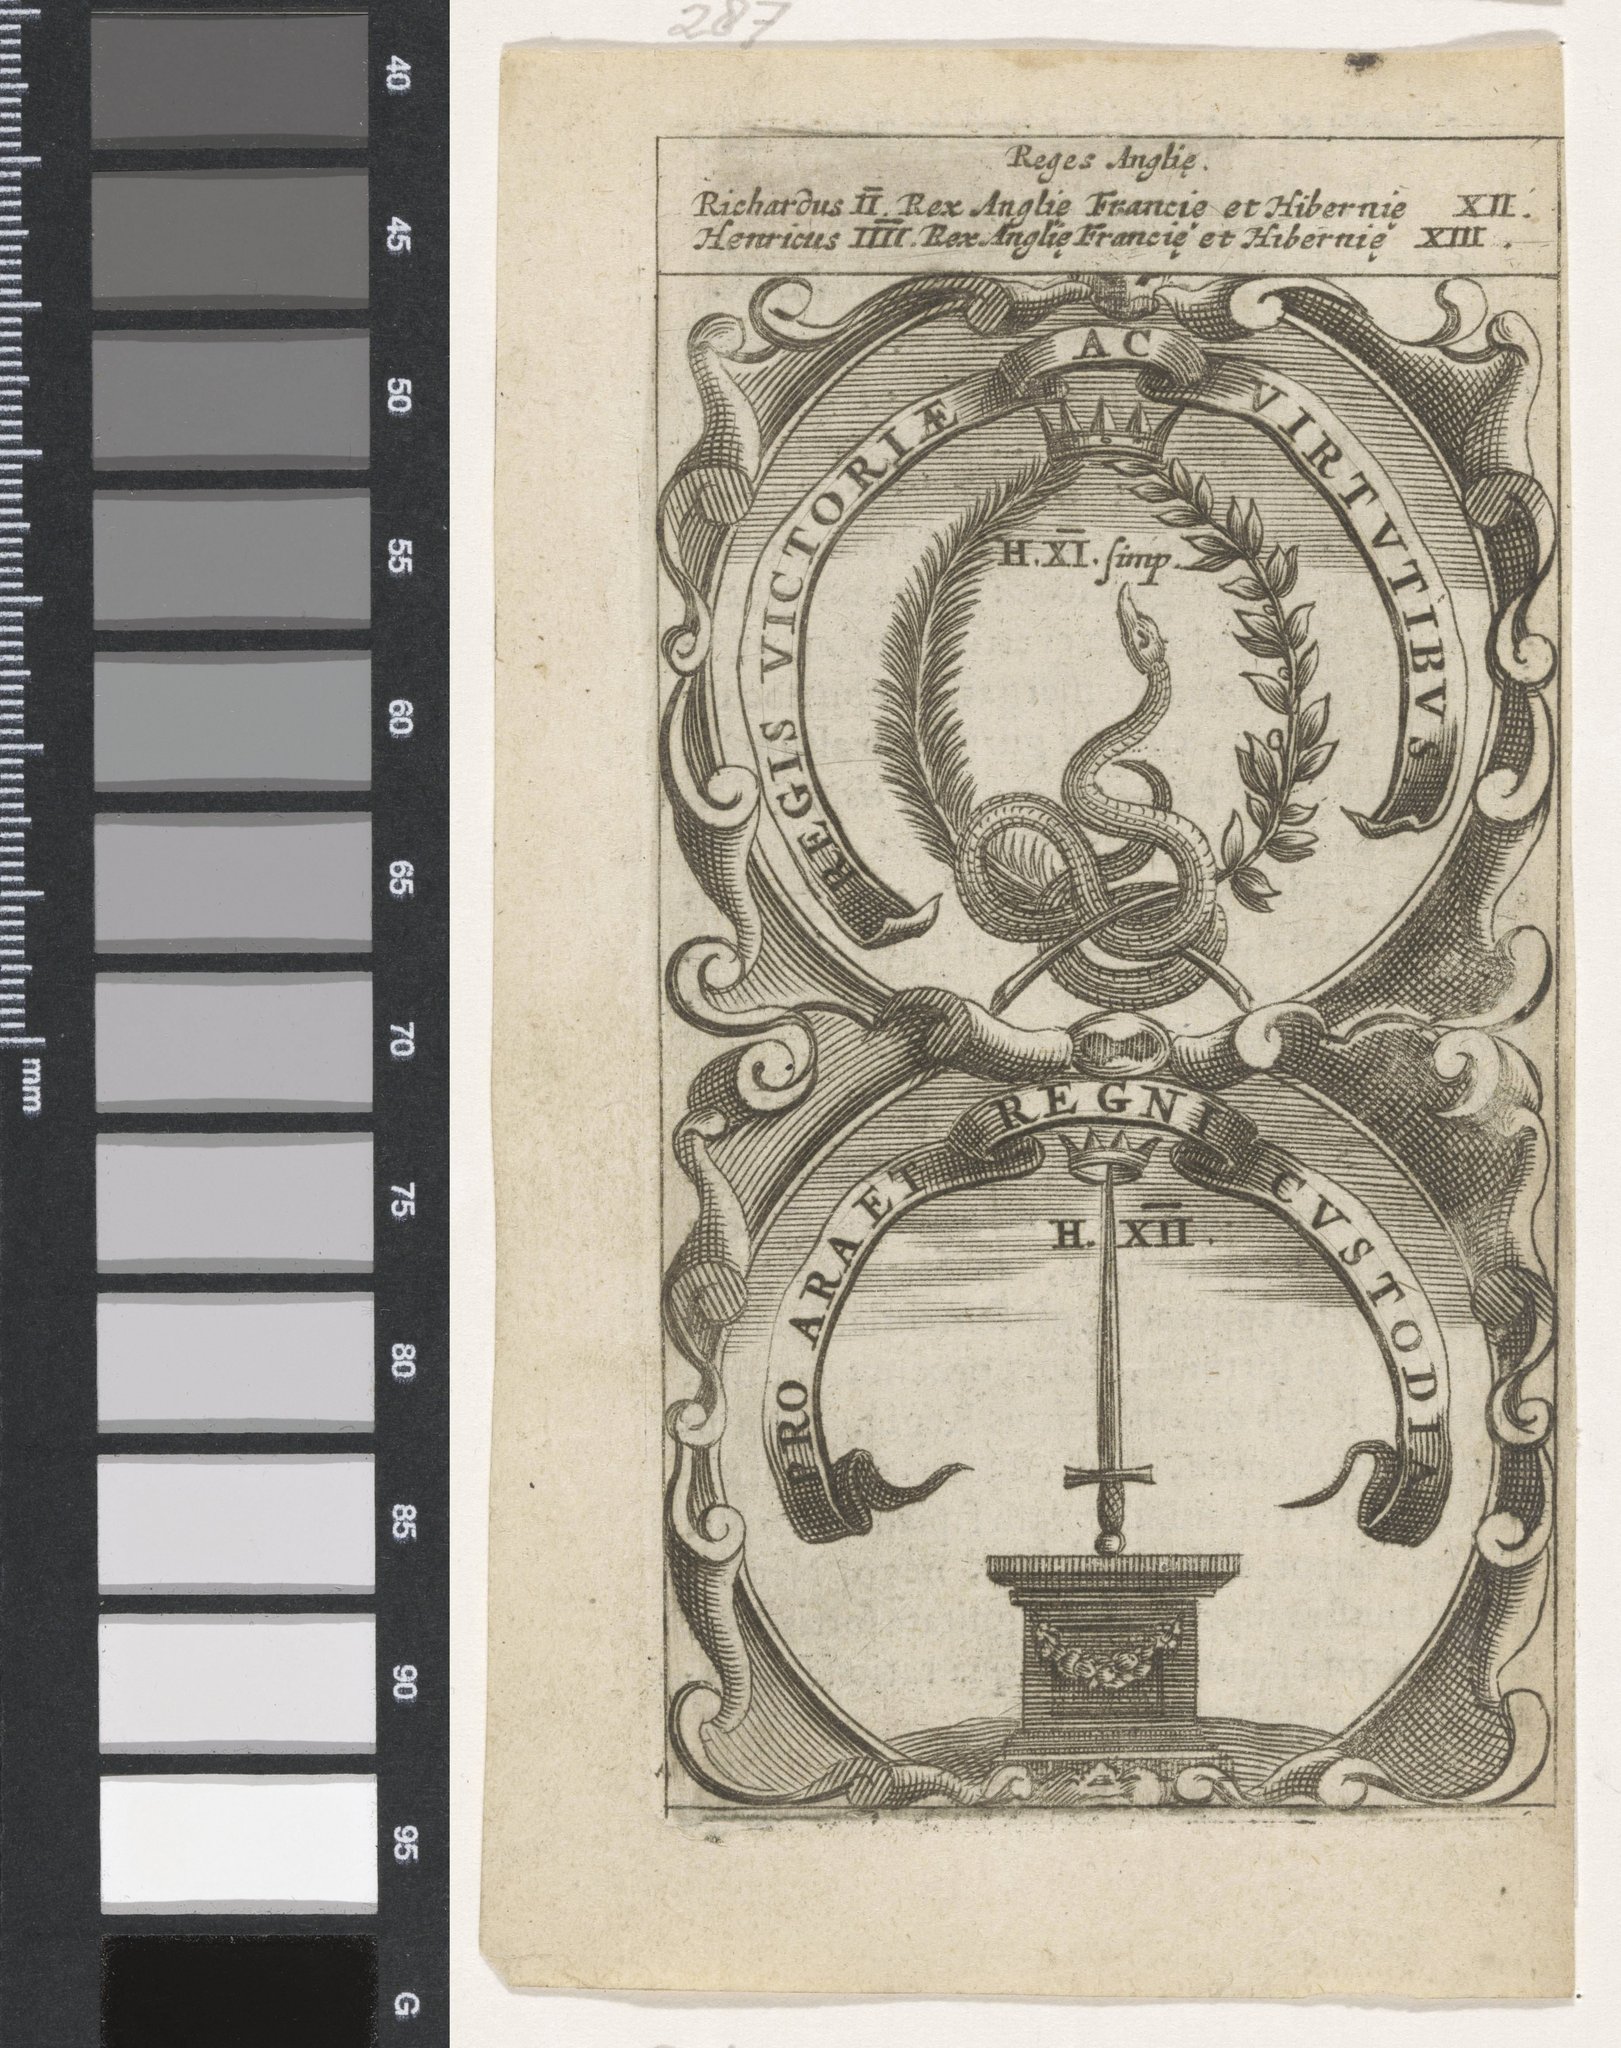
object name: book illustration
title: Regis Victoriae Ac Virtutibus / Pro Araet Regni Custodia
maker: Anonymous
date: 1666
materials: paper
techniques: engraving, letterpress printing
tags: snakes, garland, wreath, hacking and thrusting weapons: sword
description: Pagina uit Jacob Typotius, Symbola Divina & Humana Pontificum Imperatorum Regum. Arnhem, J.F. Hagen, 1666 of uit de titeluitgave van 1669 of 1679. Het werk van Typotius werd voor het eerst uitgegeven in 1601 met prenten van Aegidius Sadeler.